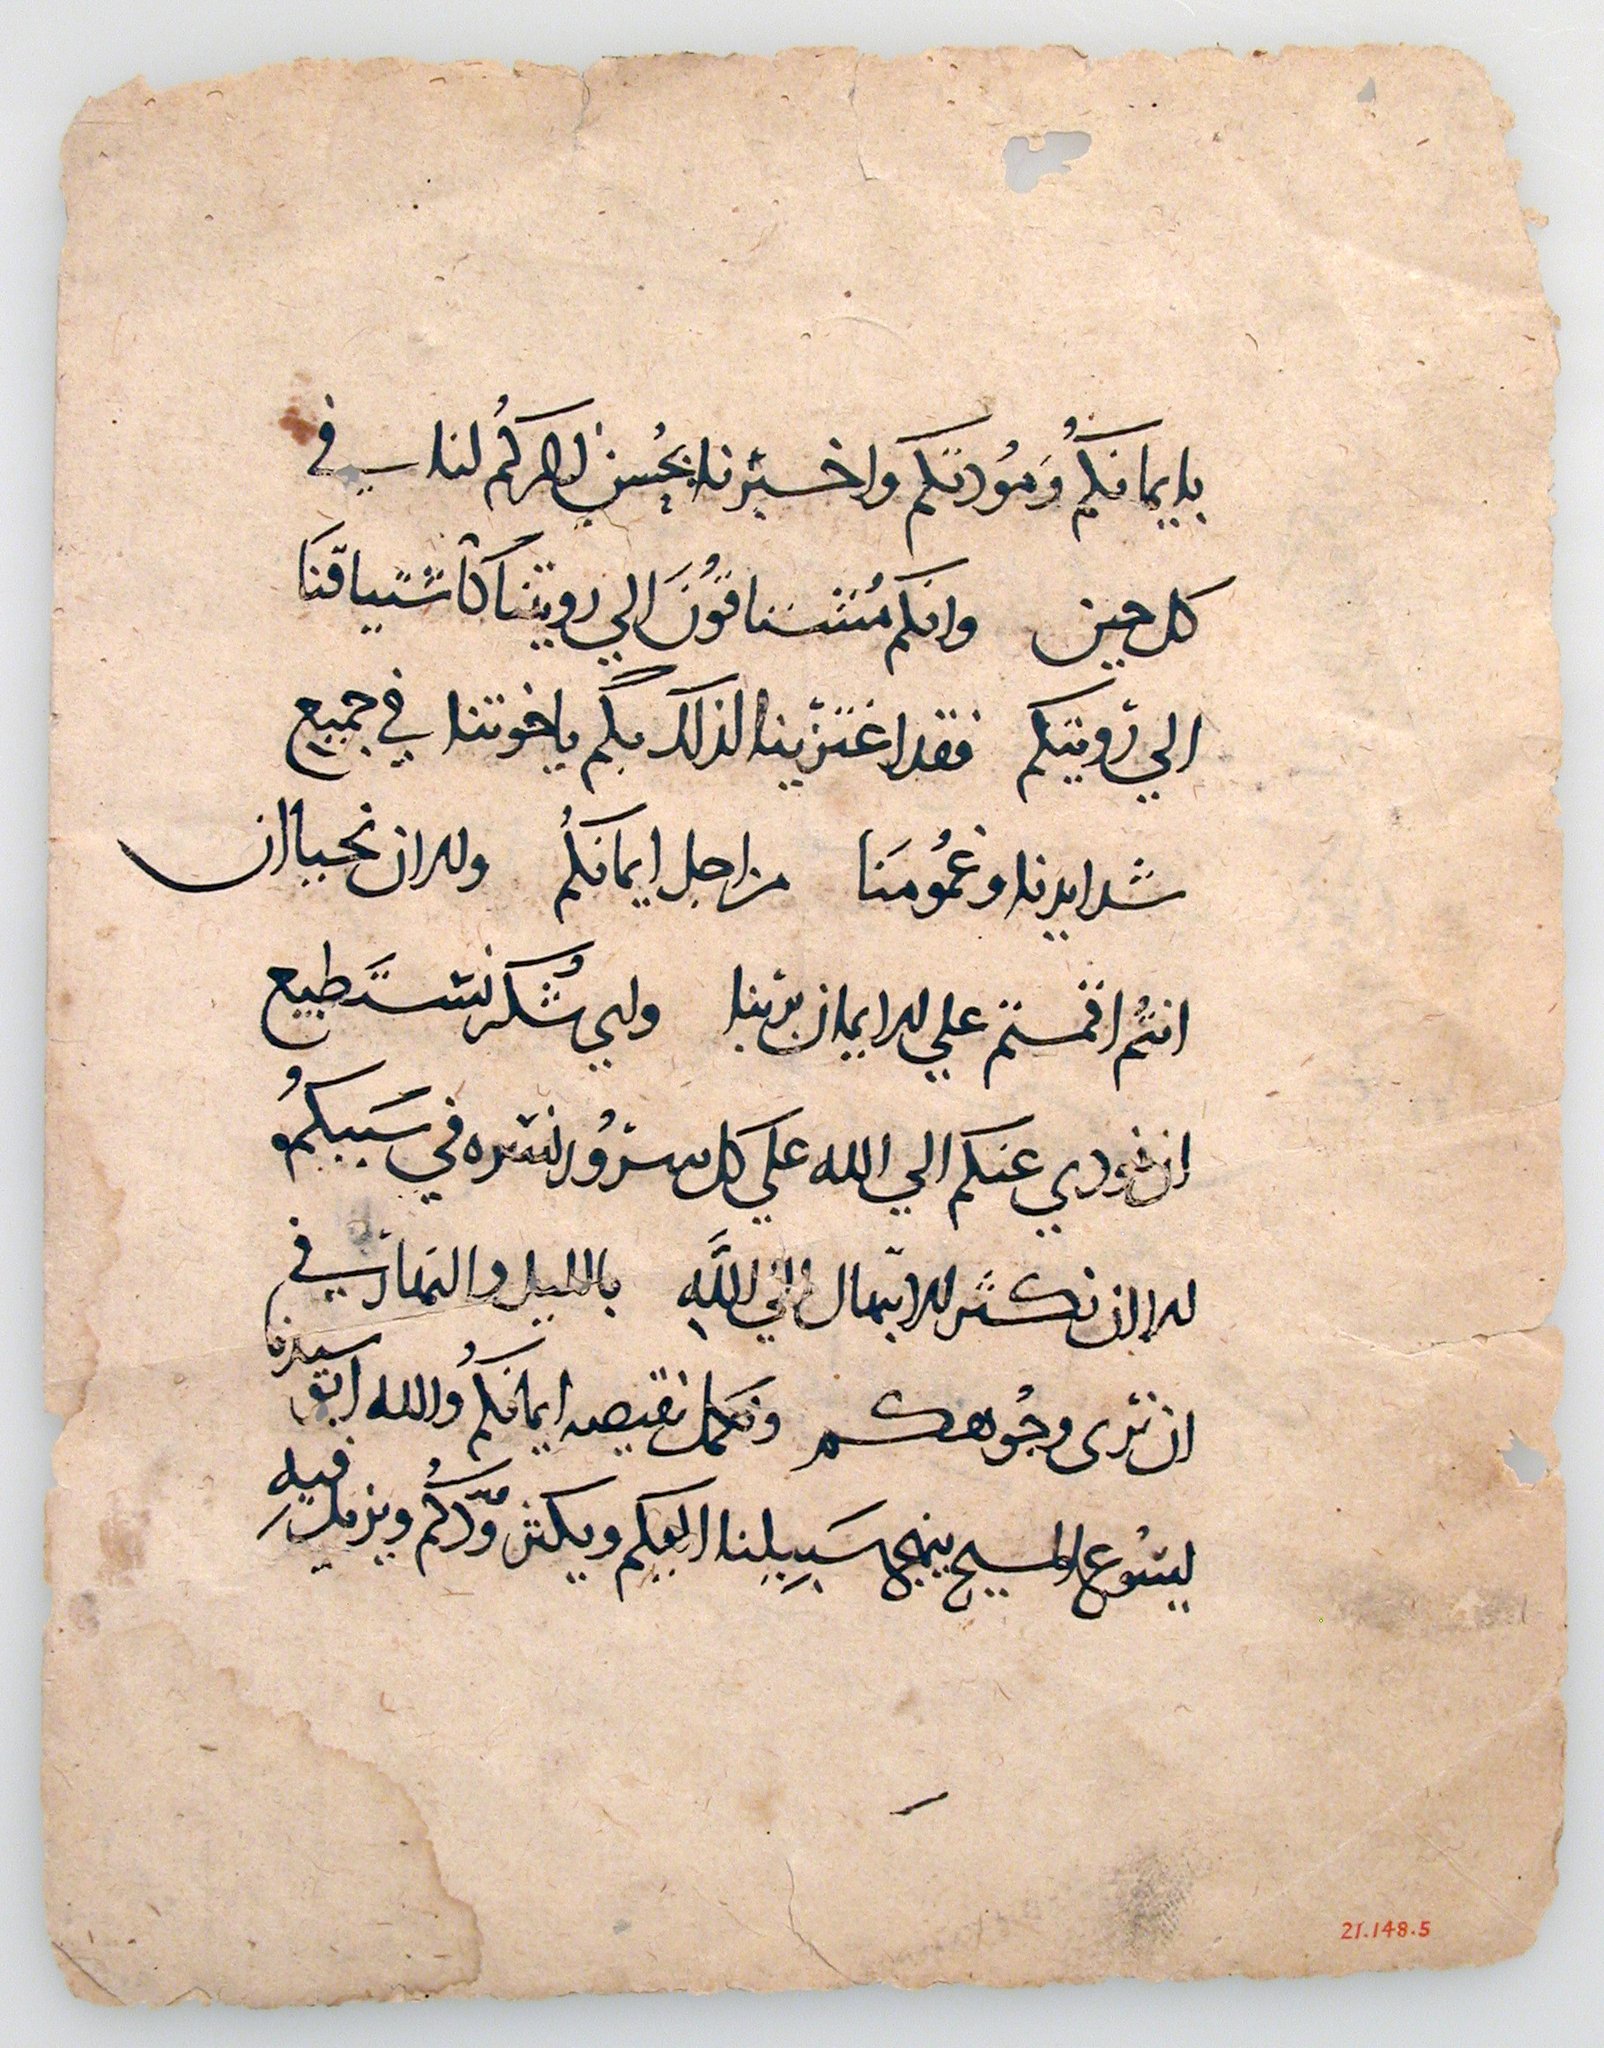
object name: manuscript leaf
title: Manuscript Leaves from an Arabic Manuscript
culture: arabic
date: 501-1400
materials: ink, paper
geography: egypt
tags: arabic